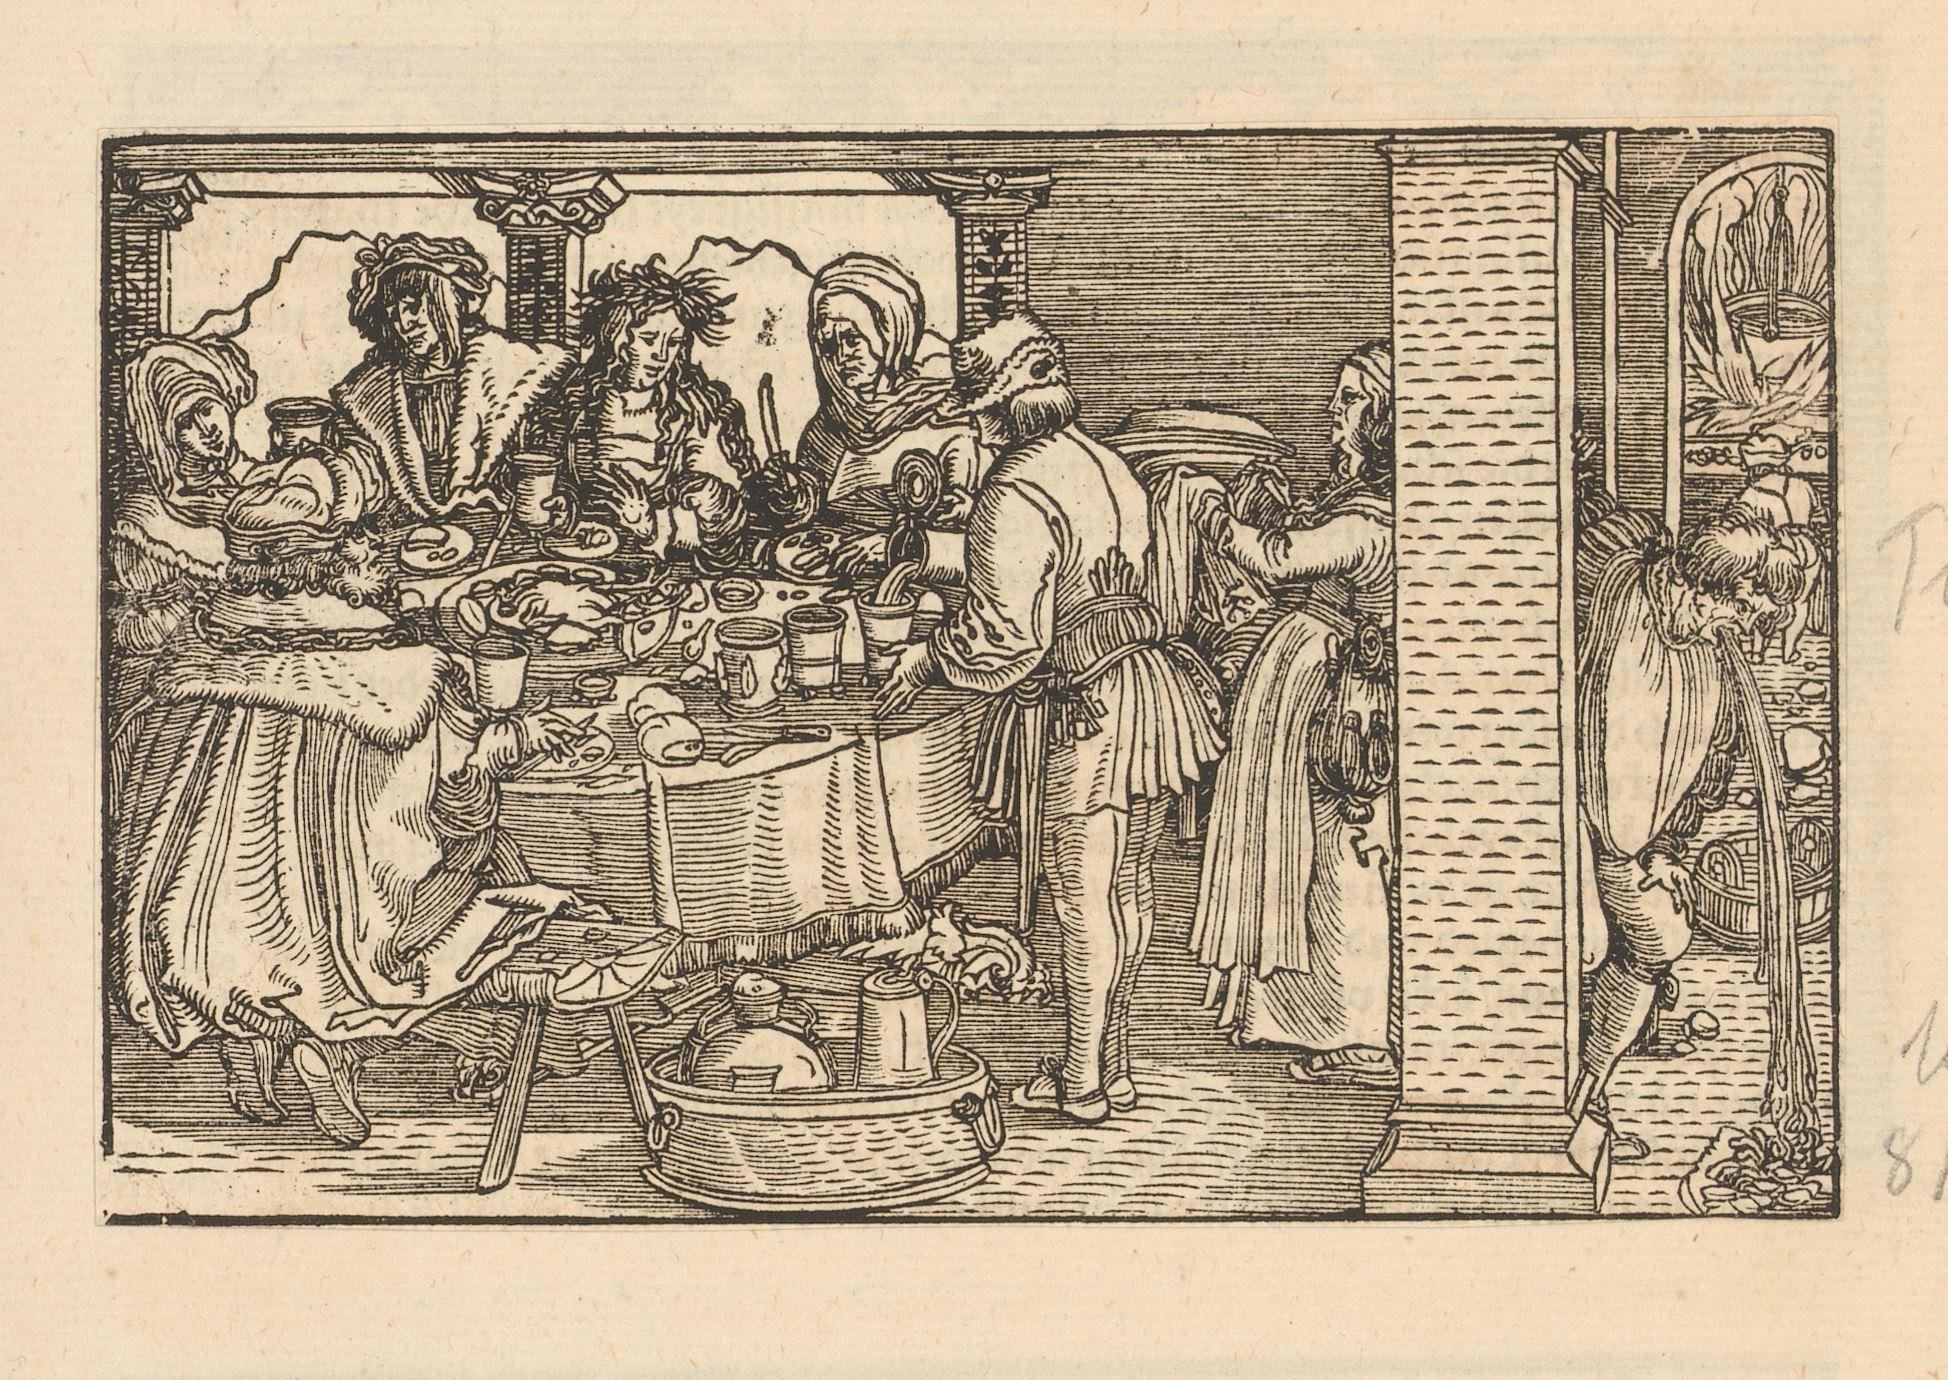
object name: album leaf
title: Gezelschap aan een overdadig diner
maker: Anonymous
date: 1514-1532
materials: paper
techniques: letterpress printing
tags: evening meal, dinner, supper, loose company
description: Deze prent is gebruikt in: Petrarca, Francesco. Von der Artzney bayder Glück, des guten und widerwertigen: unnd weß sich ain yeder inn Gelück und Unglück halten sol (...). Augsburg: Heinrich Steiner, 1532. Deze uitgave is ook bekend onder de titel 'Trostspiegel in Glück und Unglück'.